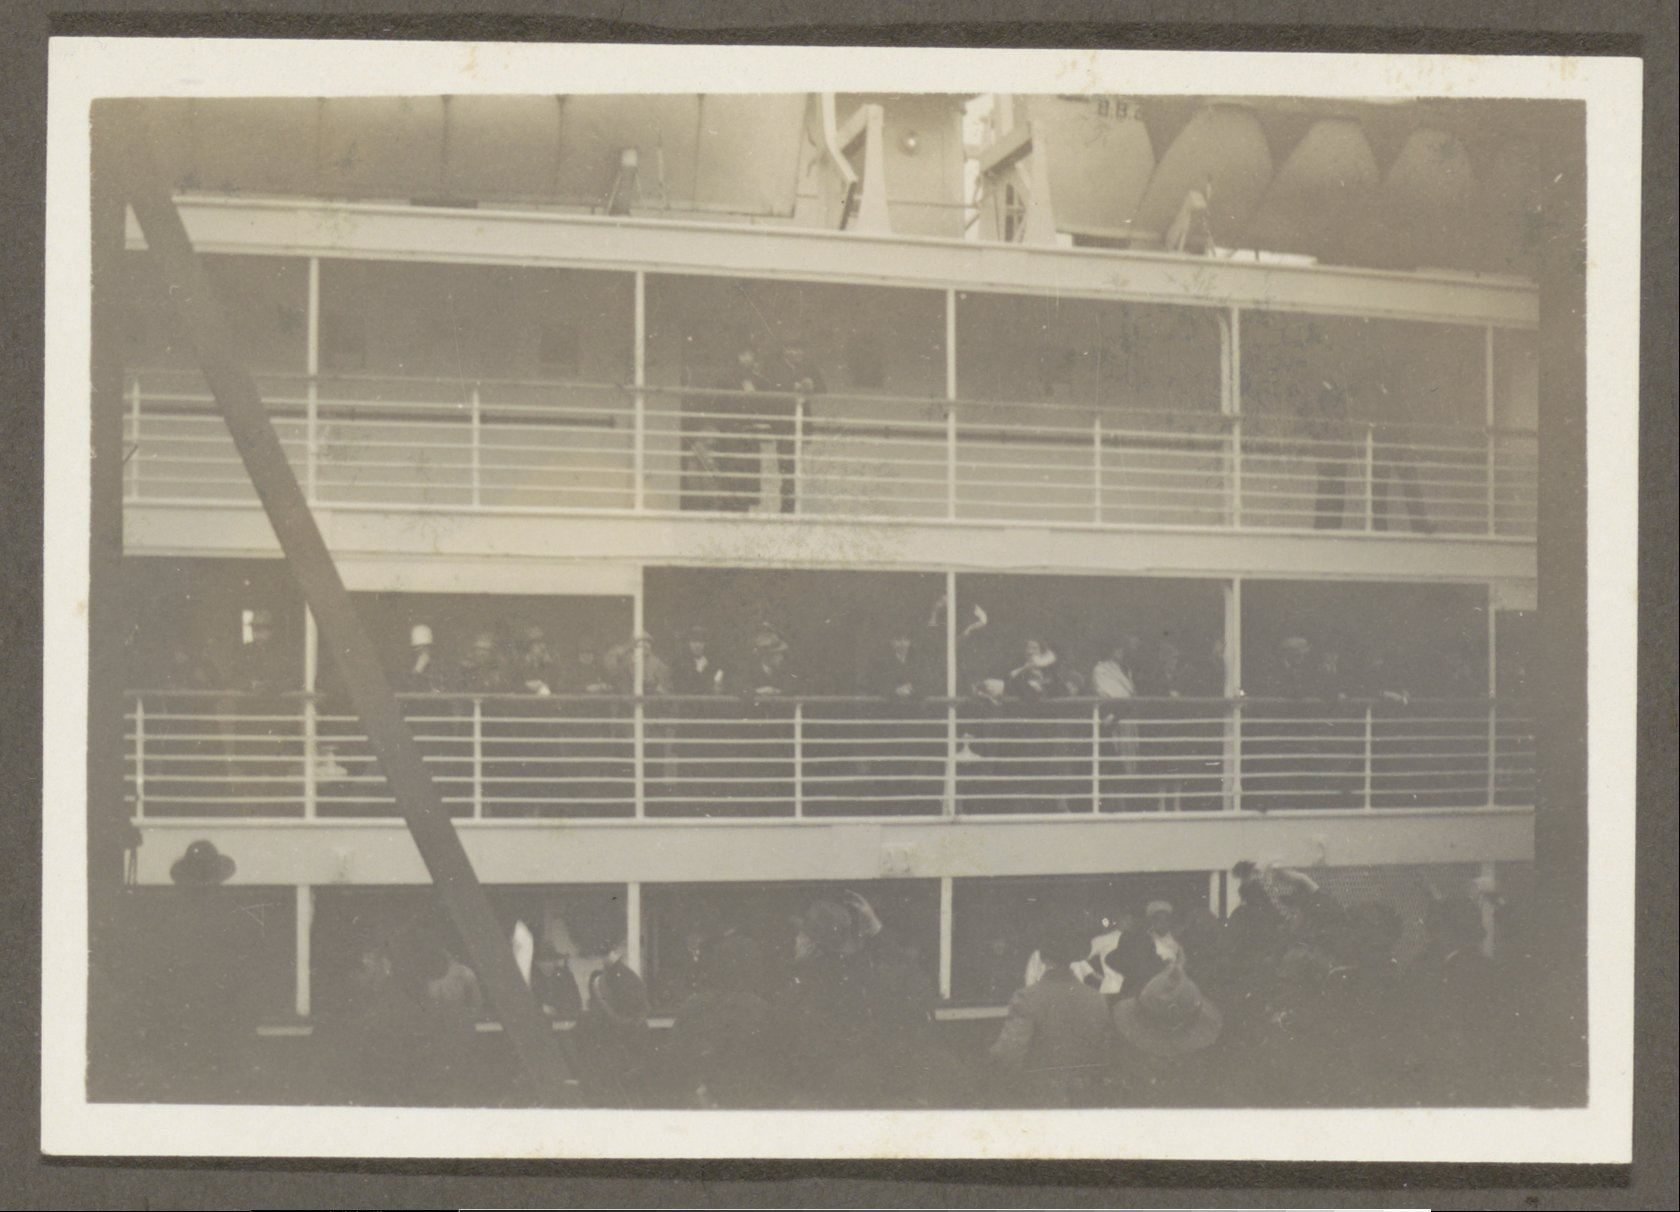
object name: photograph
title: Wuivende passagiers op een schip en achterblijvers op een kade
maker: Anonymous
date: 1920-1930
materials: photographic support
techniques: gelatin silver print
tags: waving farewell ~ departure on a journey (+ exterior ~ vehicle, ship, etc.), netherlands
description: Onderdeel van familiealbum Nederlands-Indië.